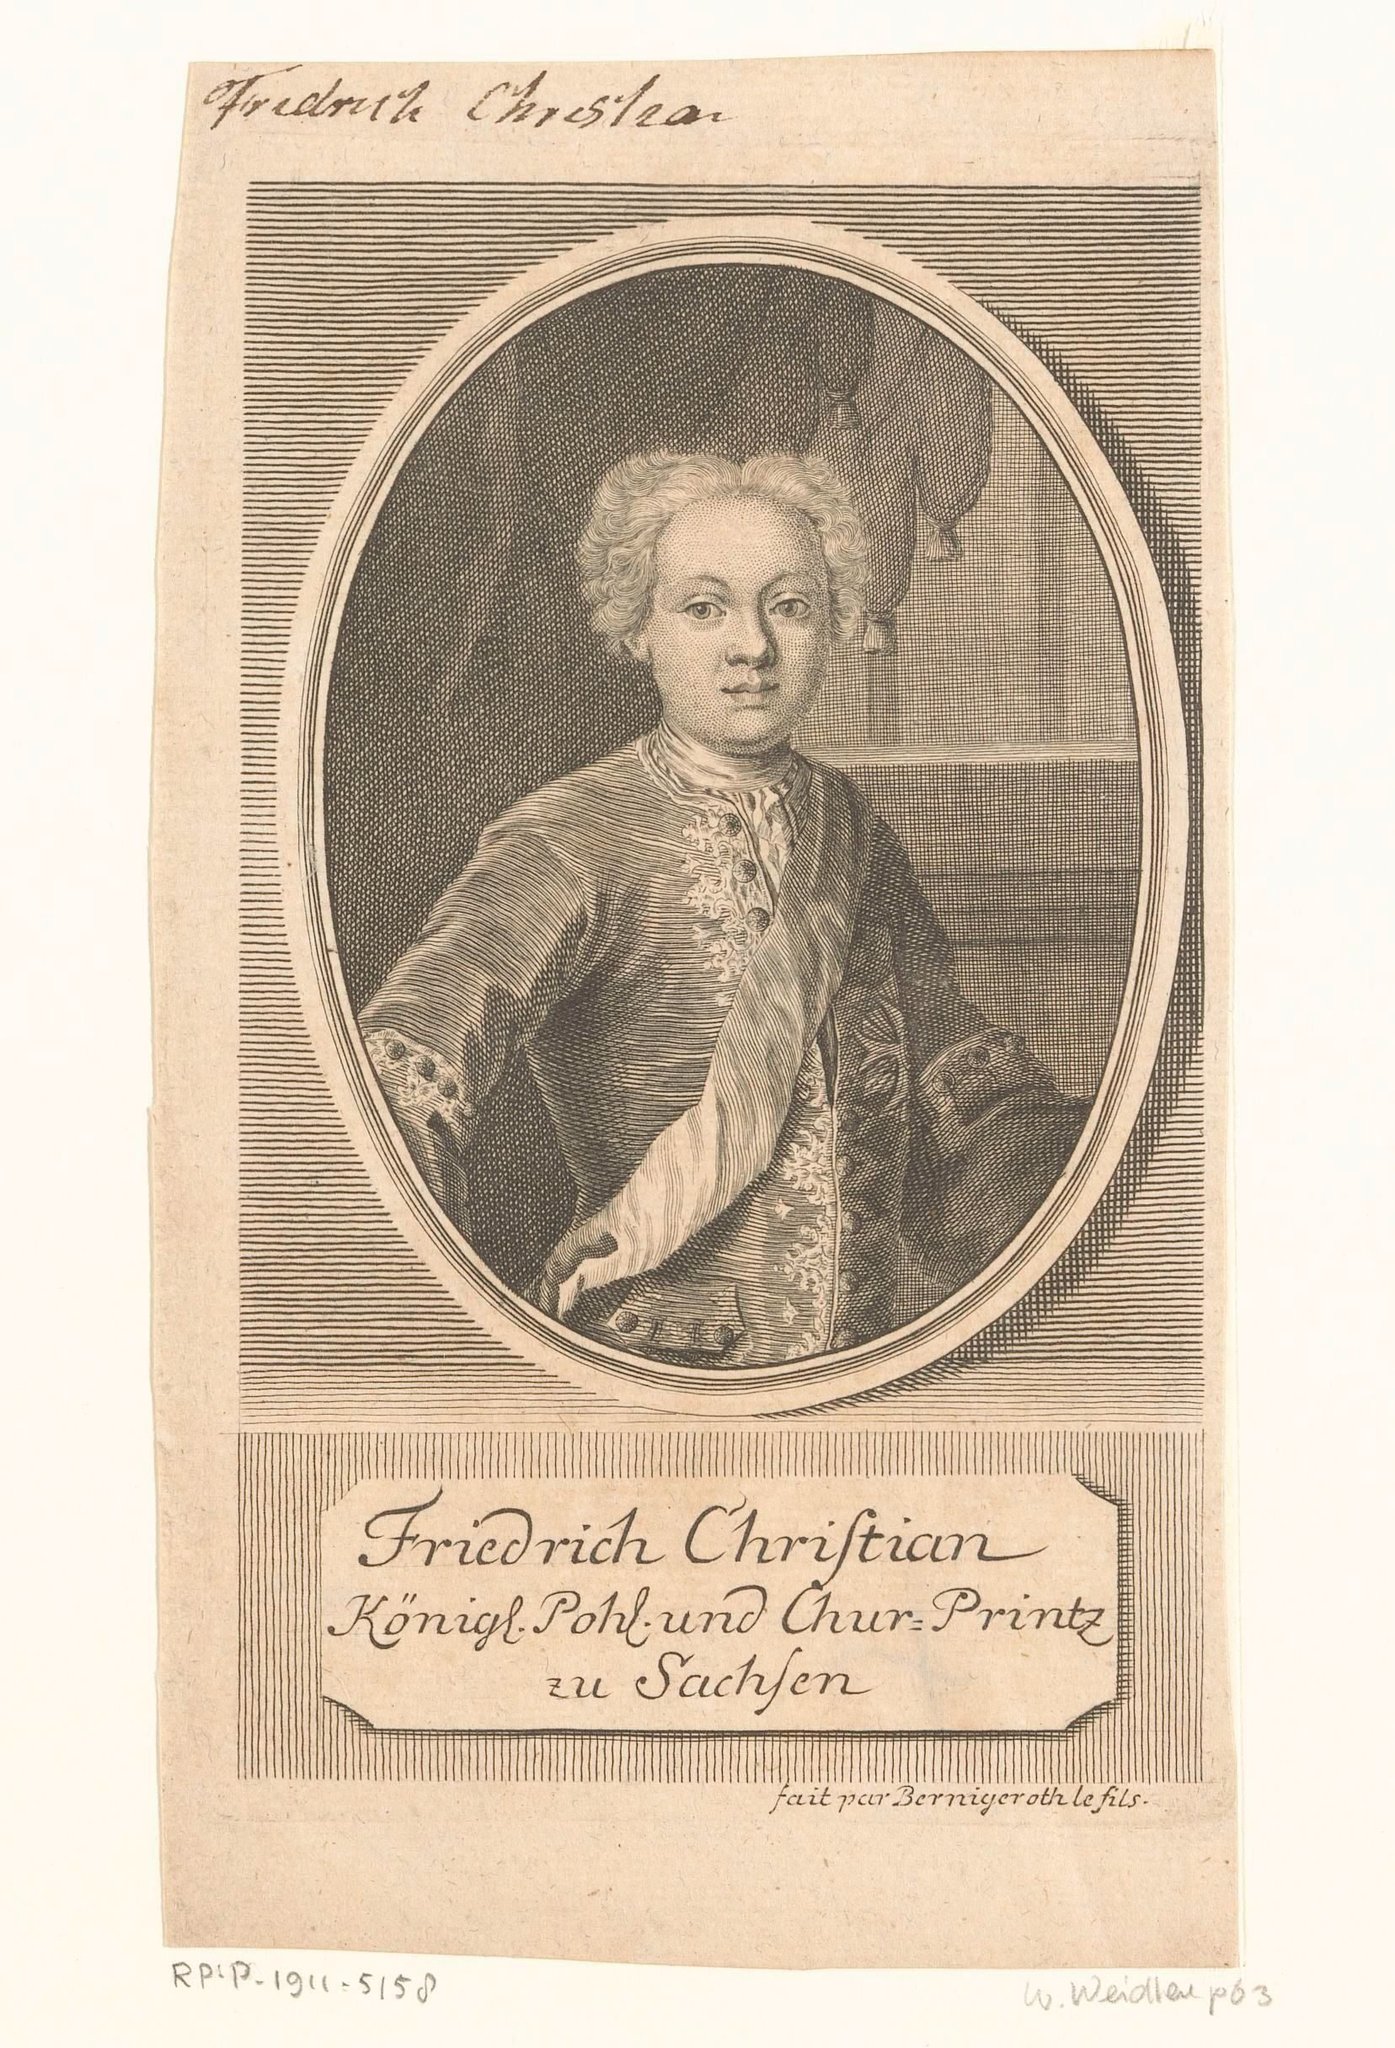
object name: print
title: Portret van Friedrich Christian von Sachsen als kroonprins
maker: johann martin bernigeroth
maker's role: print maker, publisher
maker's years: 1713-1767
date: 1723-1763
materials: paper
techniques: engraving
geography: leipzig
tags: frederik christiaan keurvorst van saksen, historical persons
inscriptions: collector's mark: Lugt 2228